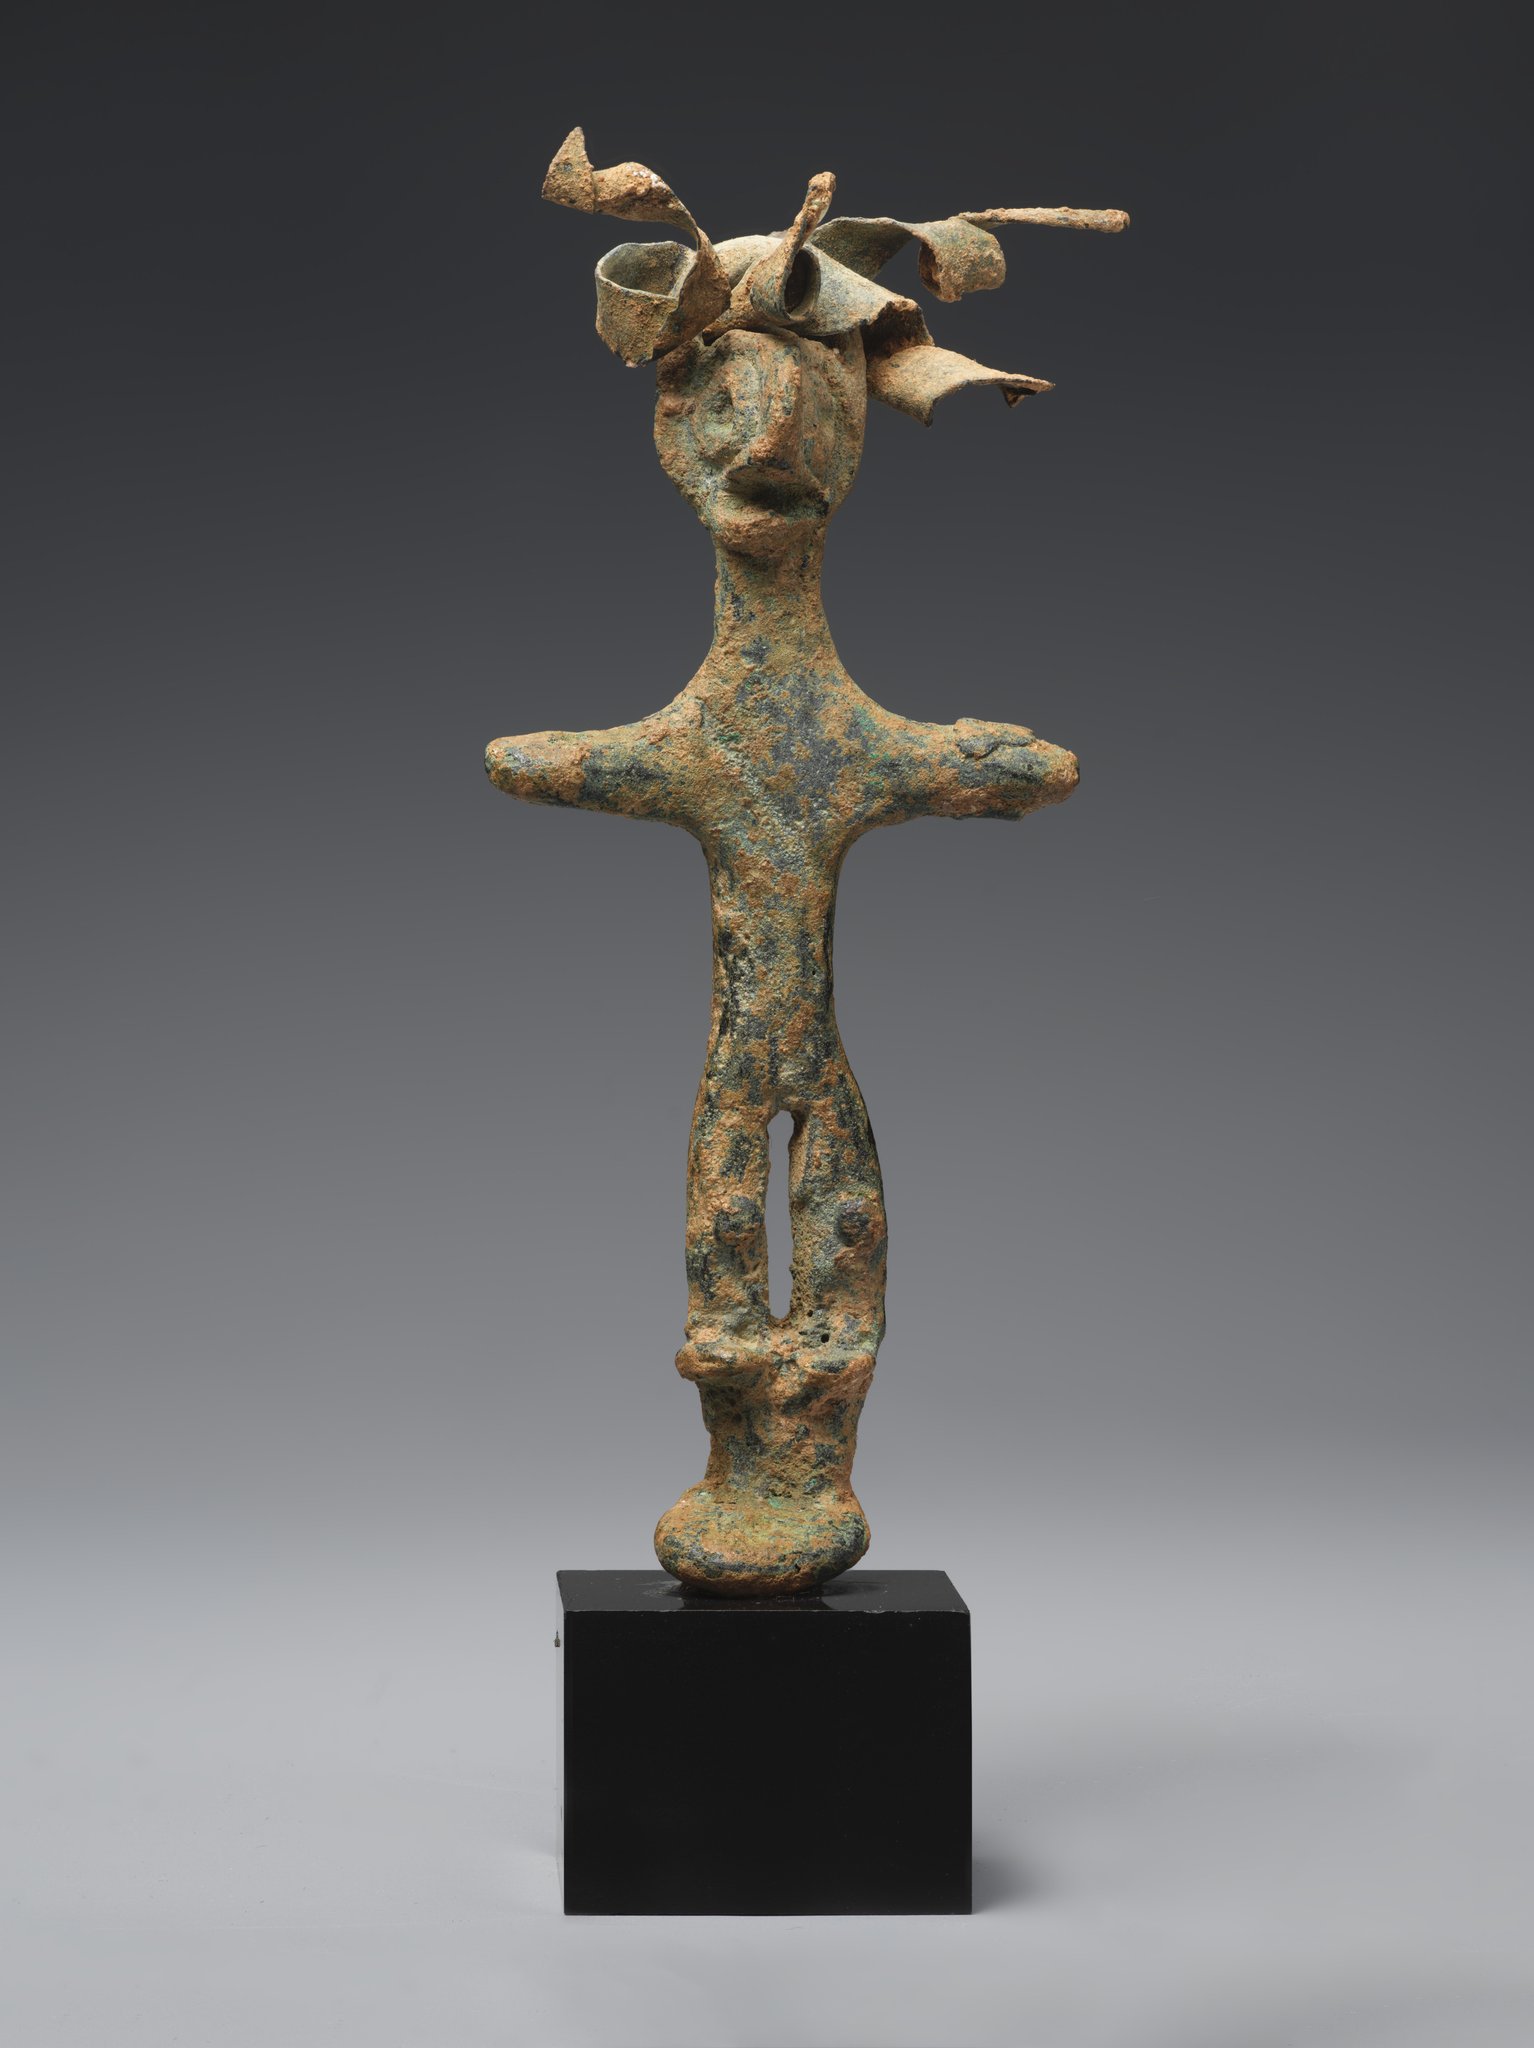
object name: sculpture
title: Standing figure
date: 2000-1668 BCE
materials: copper alloy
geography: levant